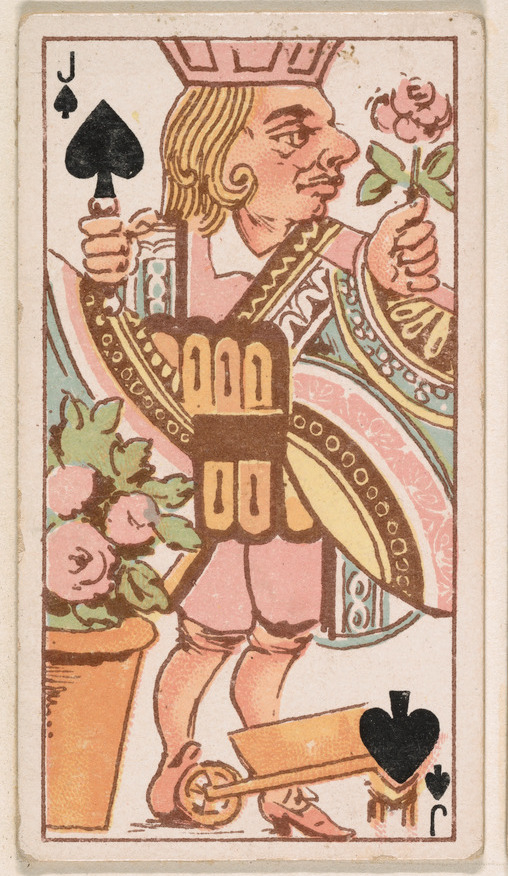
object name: print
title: Jack of Spades, from Harlequin Cards, 2nd Series (N220) issued by Kinney Bros.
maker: kinney brothers tobacco company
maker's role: publisher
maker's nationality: american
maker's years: 1869-2011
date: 1889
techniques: color lithograph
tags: playing cards